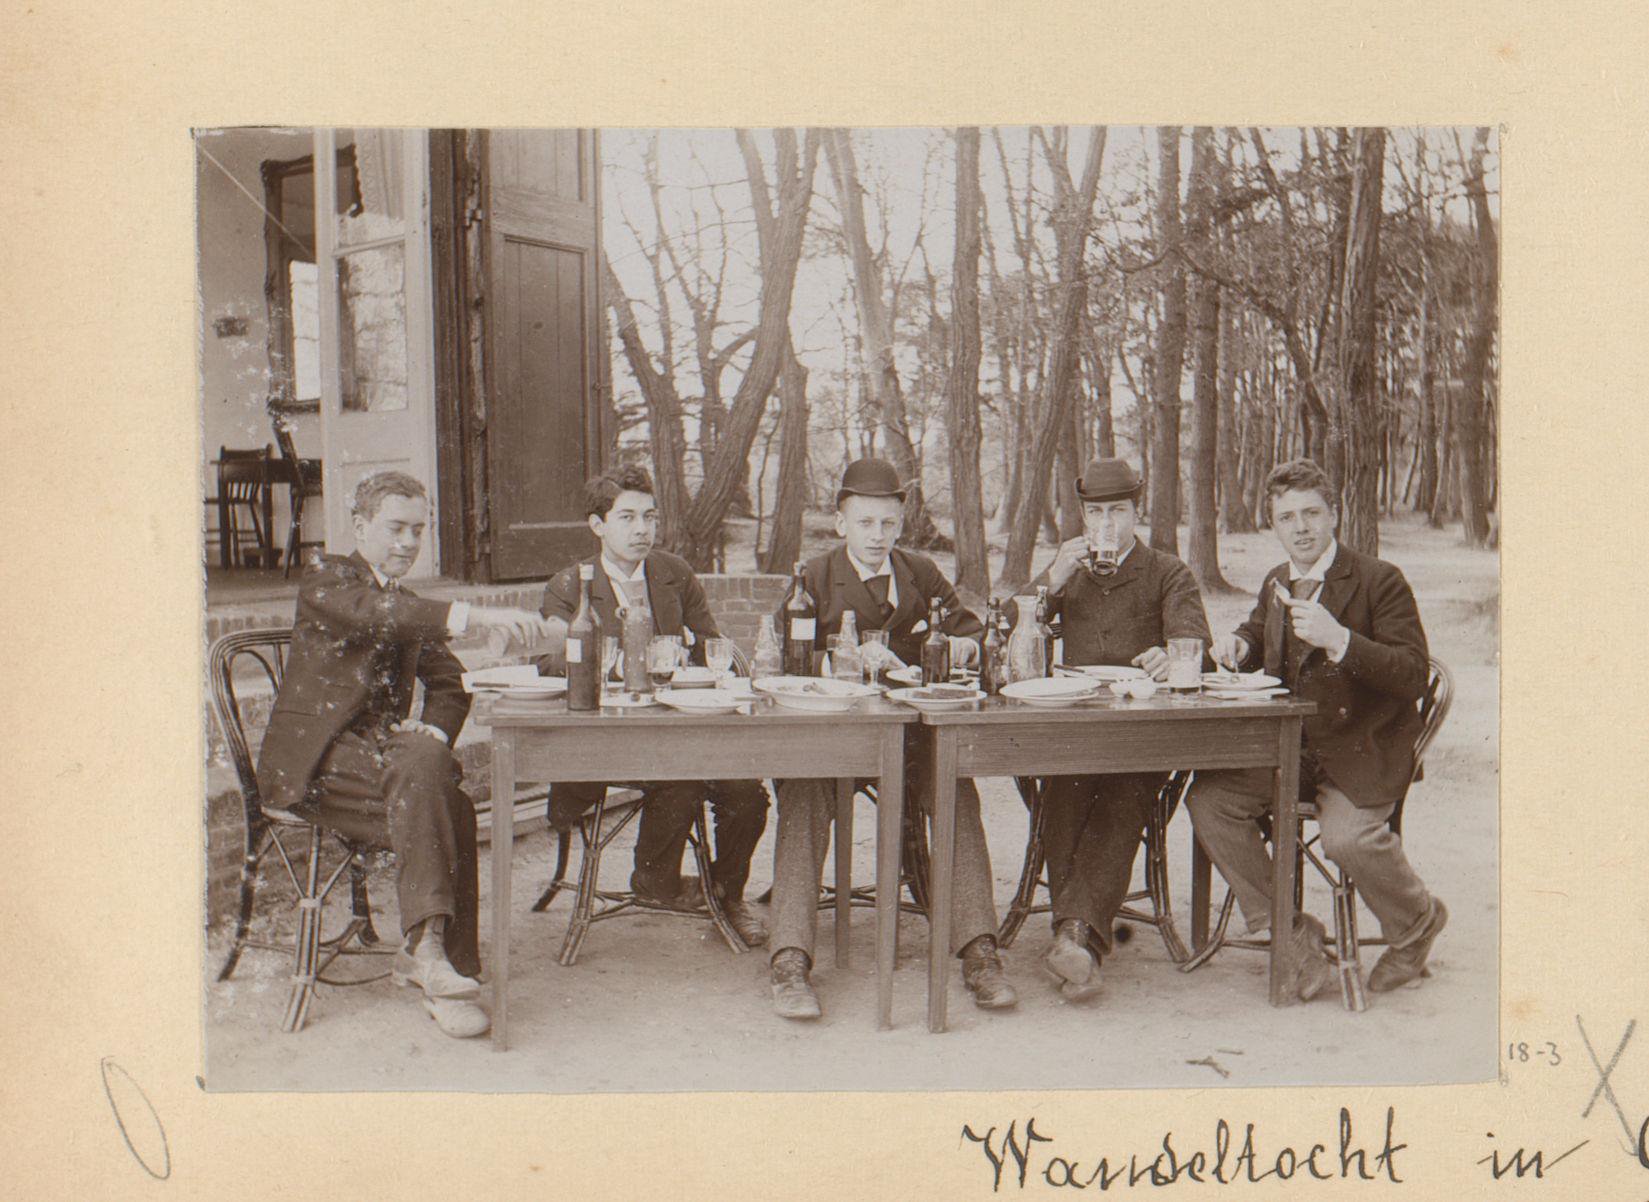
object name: photograph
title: Wandeltocht in Gelderland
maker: hendrik herman van den berg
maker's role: amateurfotograaf, jurist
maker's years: 1875-1944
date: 1890-1894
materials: paper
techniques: collodion silver print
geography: gelderland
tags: evening meal, dinner, supper - cc - out of doors, historical persons, gelderland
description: Foto 3 op albumblad 18 uit album "Amsterdam 1890-1894".